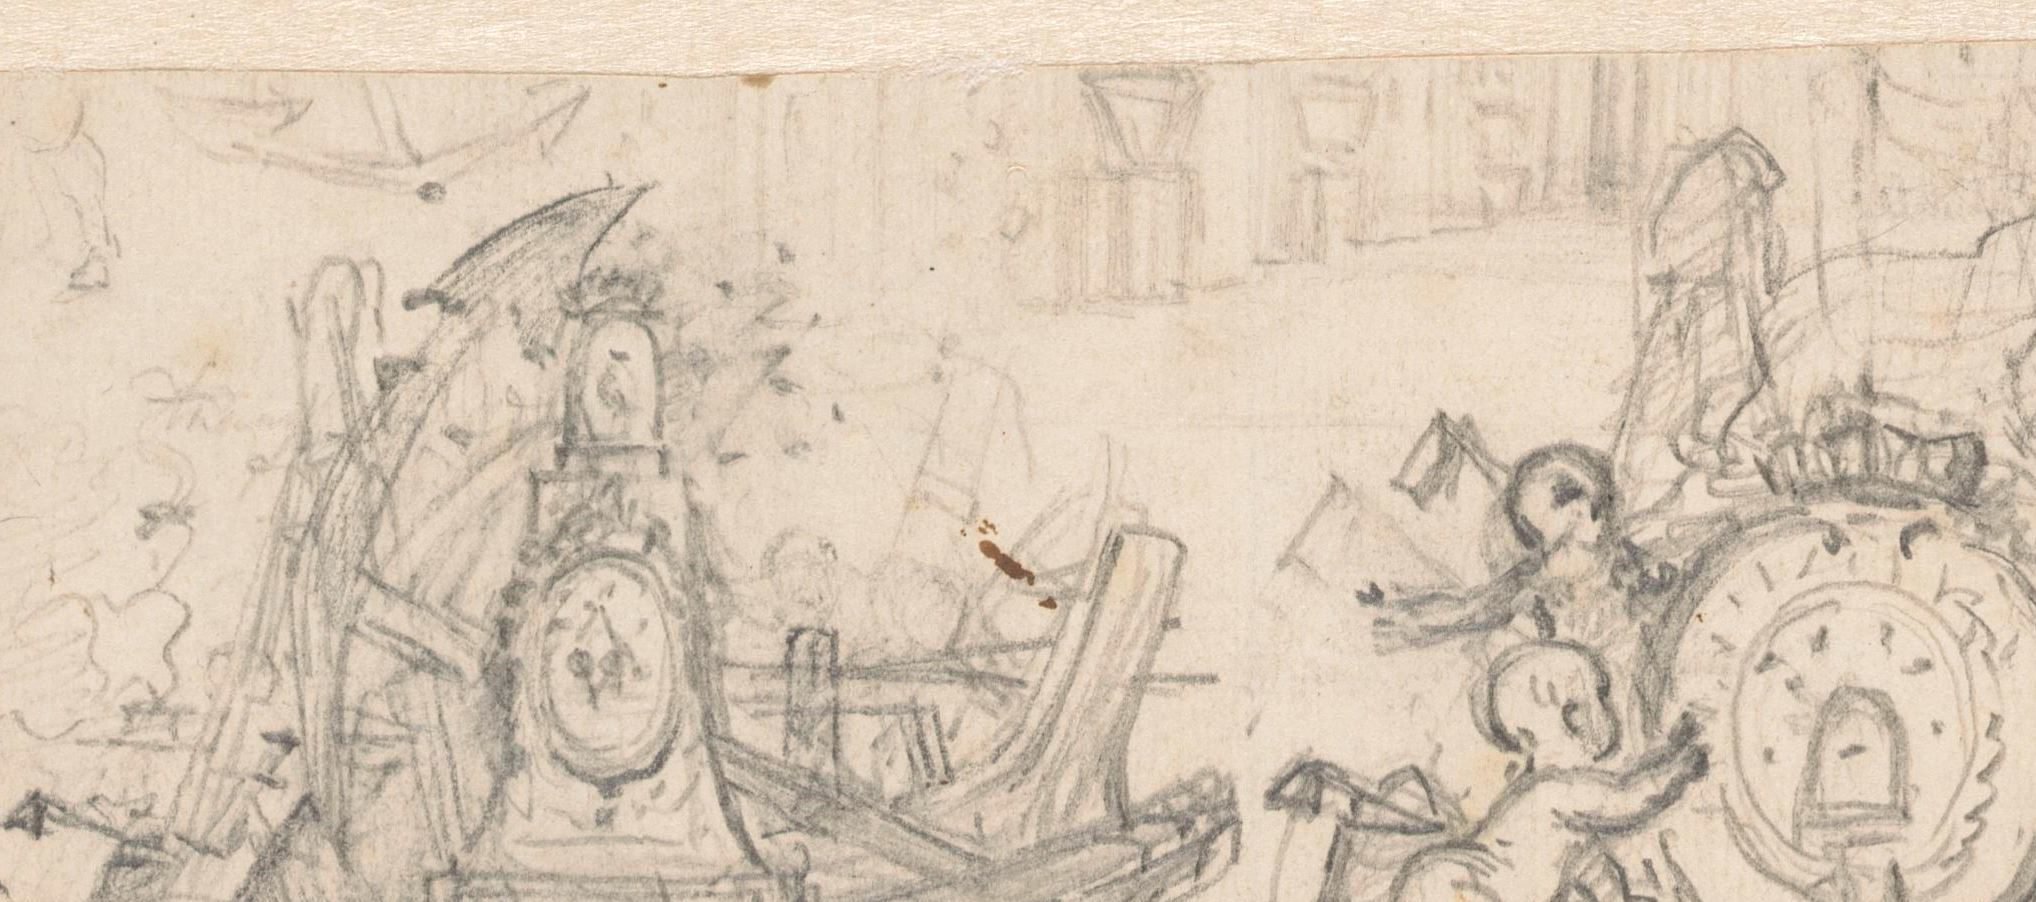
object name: drawing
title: Schets van putti met symbolen met betrekking tot de VOC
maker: jurriaan andriessen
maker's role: draughtsman, painter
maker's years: 1742-1819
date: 1752-1819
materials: graphite, paper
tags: organization of trade and finance, names of organizations, companies, trade unions, etc., trade, commerce and finance, 'navigatione' (ripa)